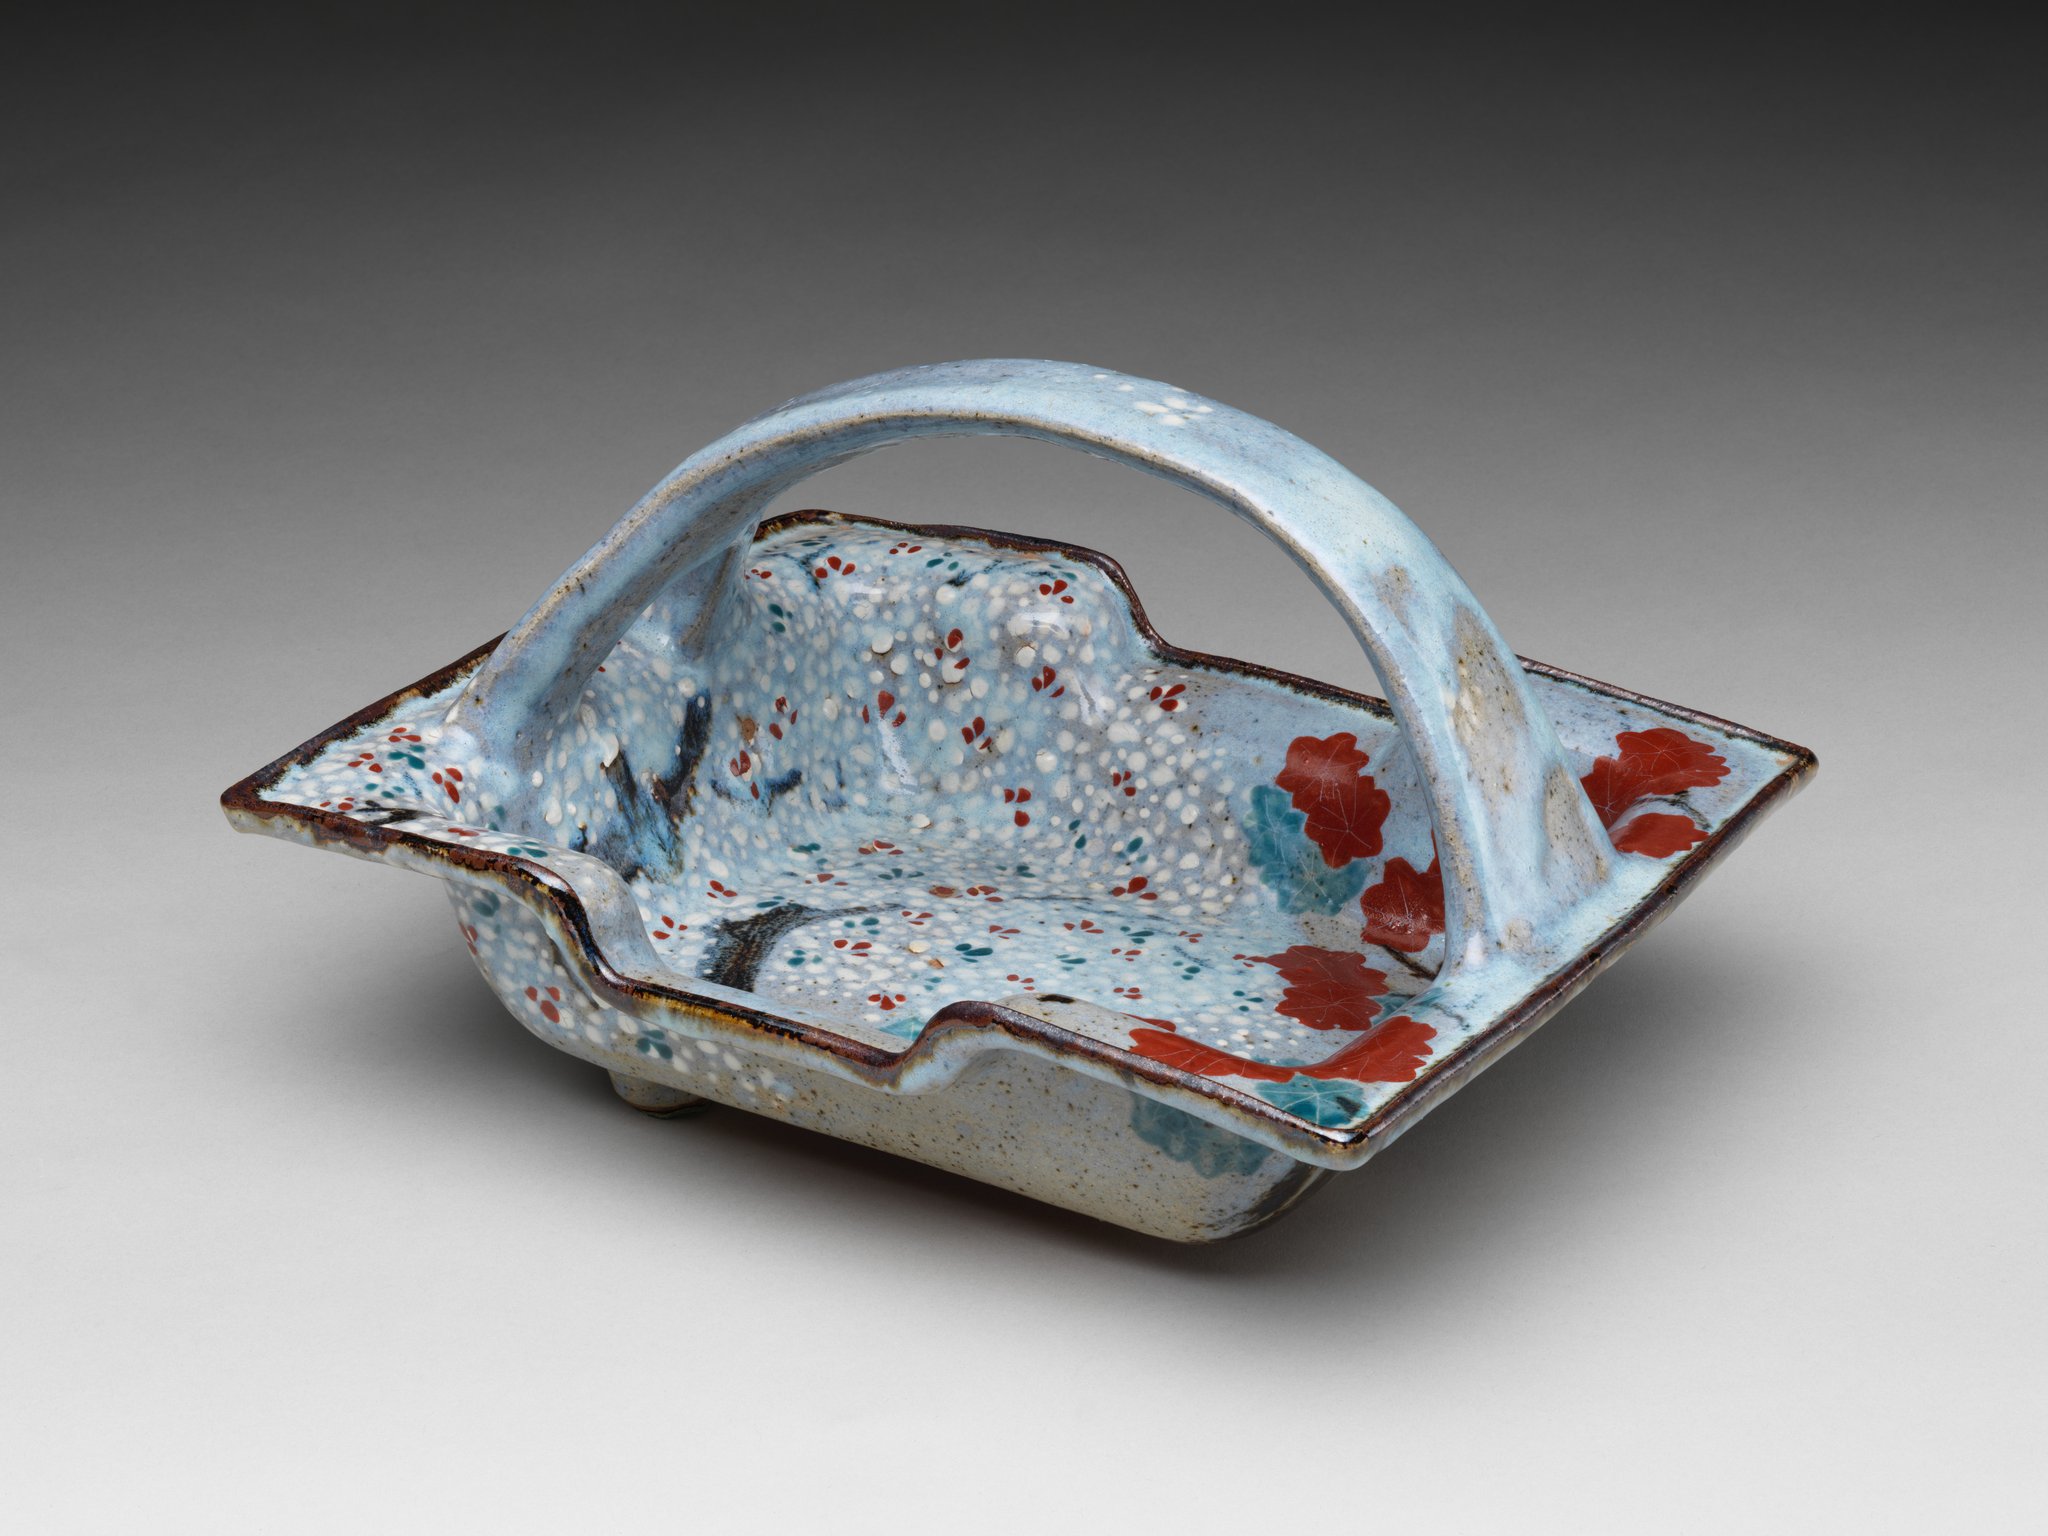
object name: tray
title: Handled tray with cherry blossoms and maples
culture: japanese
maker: nin'ami dōhachi (takahashi dōhachi ii)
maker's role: artist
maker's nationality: japanese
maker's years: 1783-1855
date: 1615-1868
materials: glaze, stoneware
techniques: polychrome